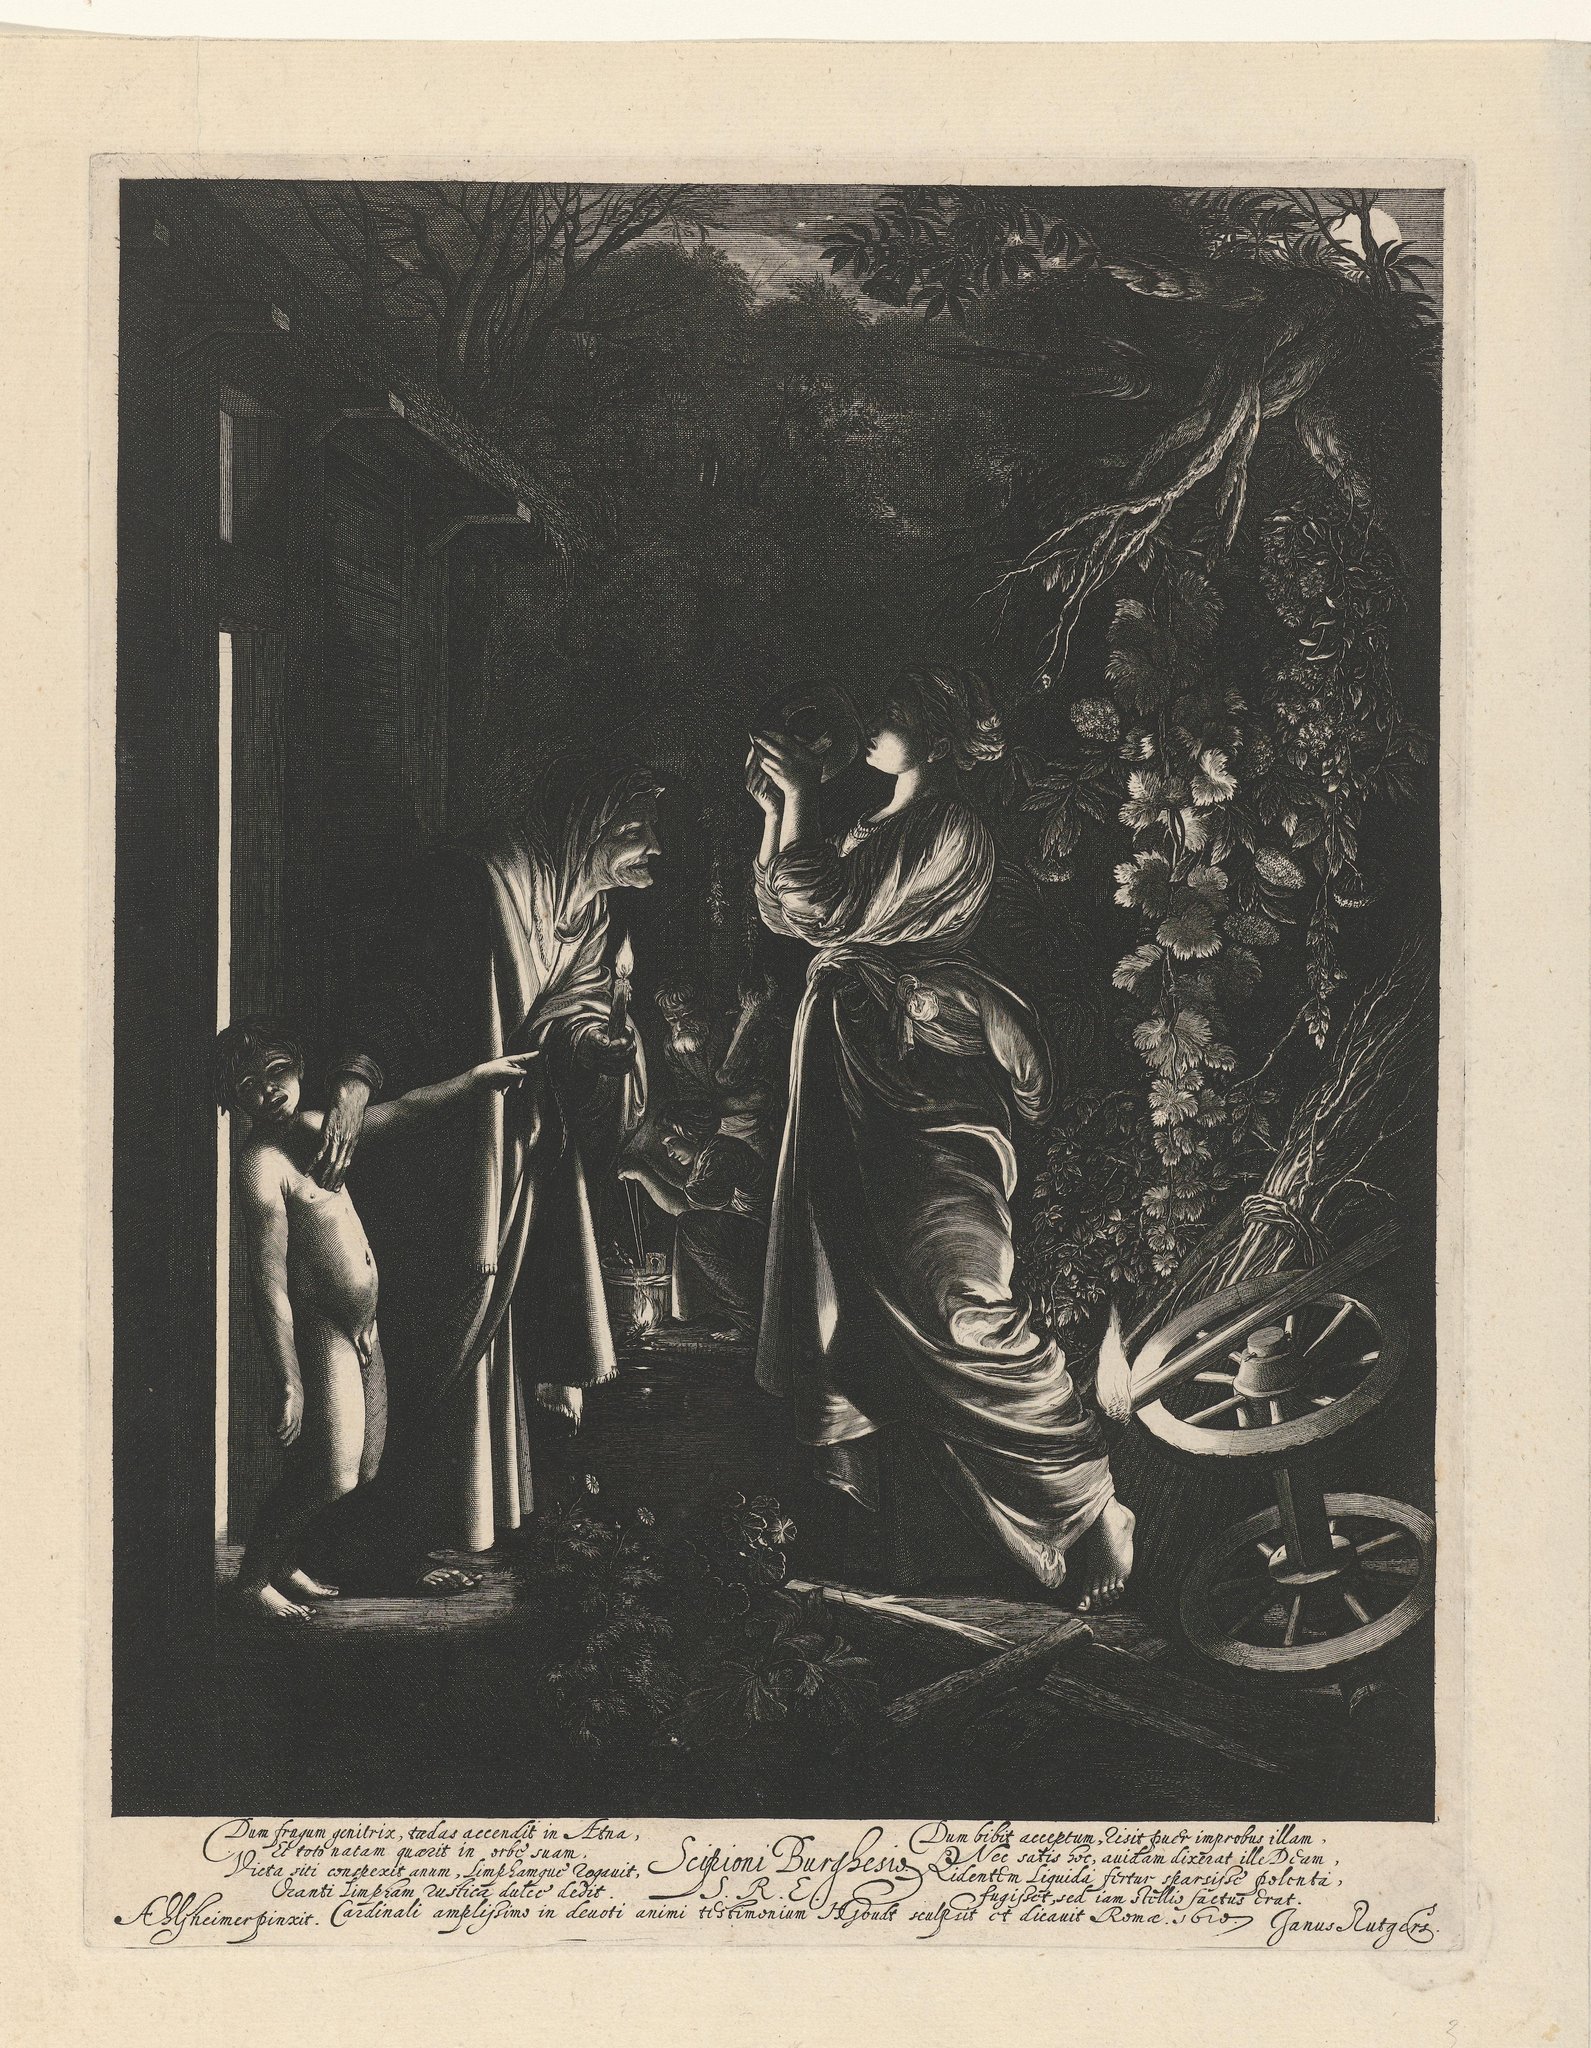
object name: print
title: Bespotting van Ceres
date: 1610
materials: paper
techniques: engraving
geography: rome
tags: a little boy (abas, ascalabus, or stellio) laughs at ceres, because she drinks too avidly while she is resting at an old woman's house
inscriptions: collector's mark: Lugt 240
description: De godin Ceres, op zoek naar haar dochter Proserpina, rust uit bij een hut. Ze drinkt uit een kruik, gegeven aan haar door een oude vrouw. Een kleine naakte jongen naast de oude vrouw wijst naar Ceres en lacht haar uit. De prent heeft een Latijns onderschrift. Naar een schilderij van Adam Elsheimer.